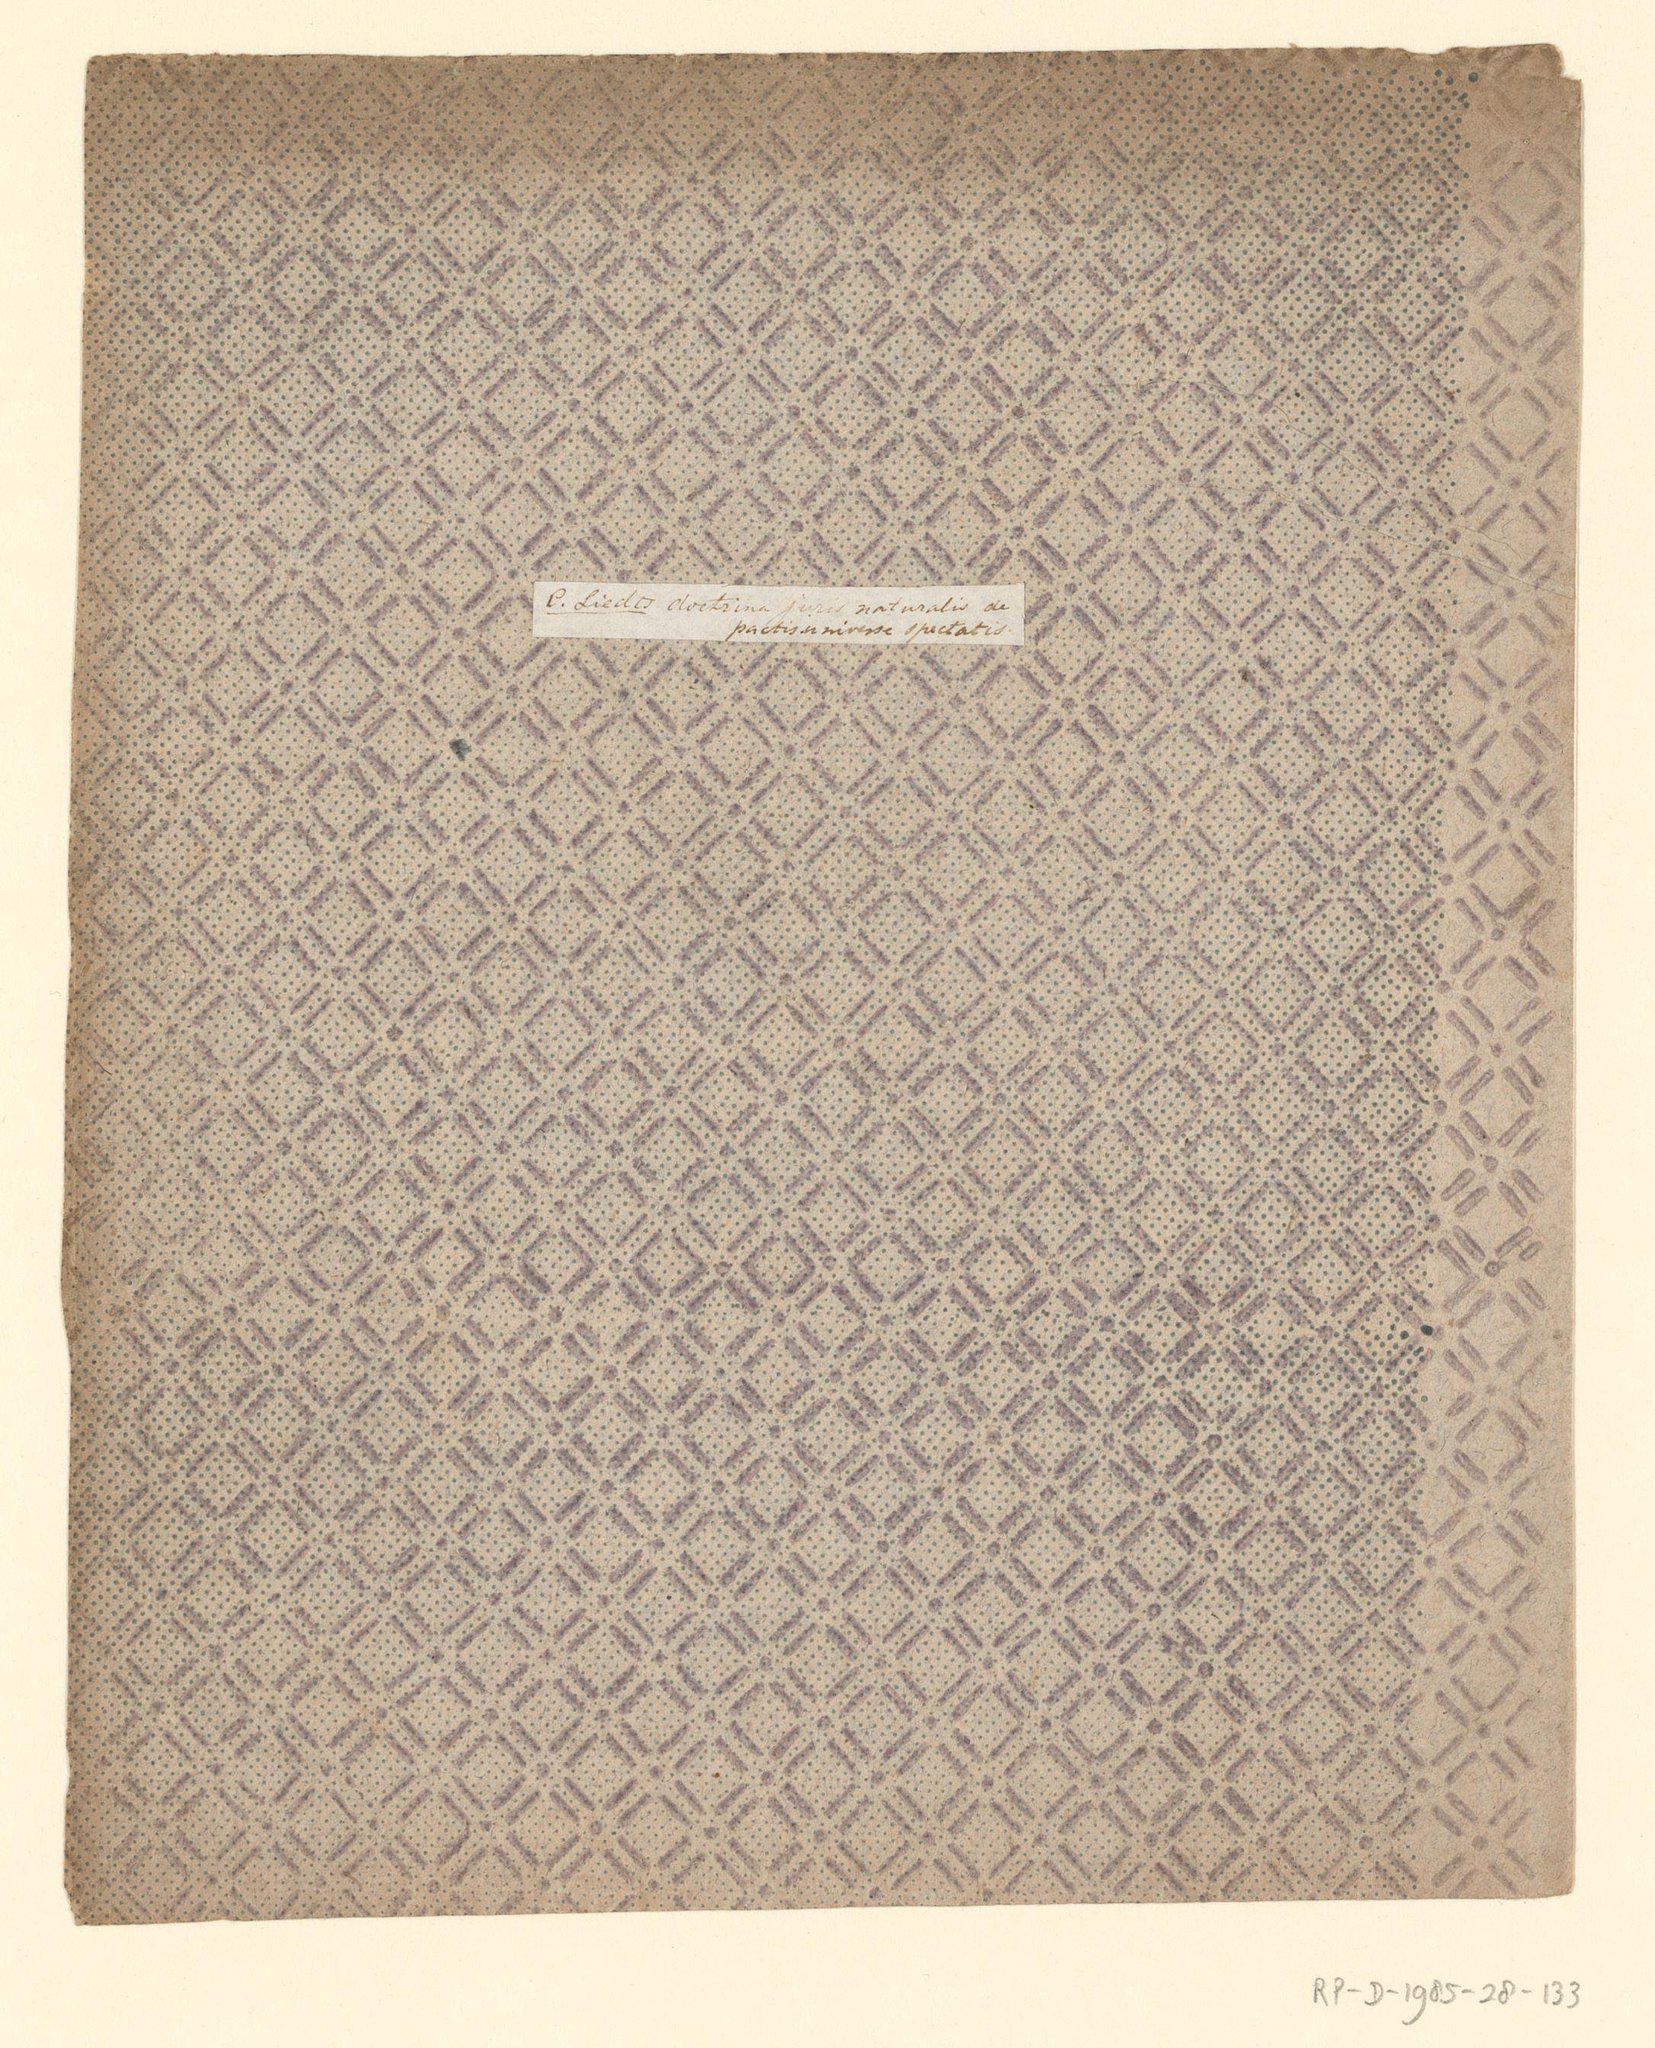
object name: wrapper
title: Blad met ruitenpatroon met puntenfond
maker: Anonymous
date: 1750-1900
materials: paper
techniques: printing block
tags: ornament ~ geometric motifs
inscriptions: collector's mark: Lugt 2760, collector's mark: Lugt 2228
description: Blad met ruitenpatroon met puntenfond. Met etiket met opschrift: 'P. Liedes ... spectatis.' Helft van een omslag.